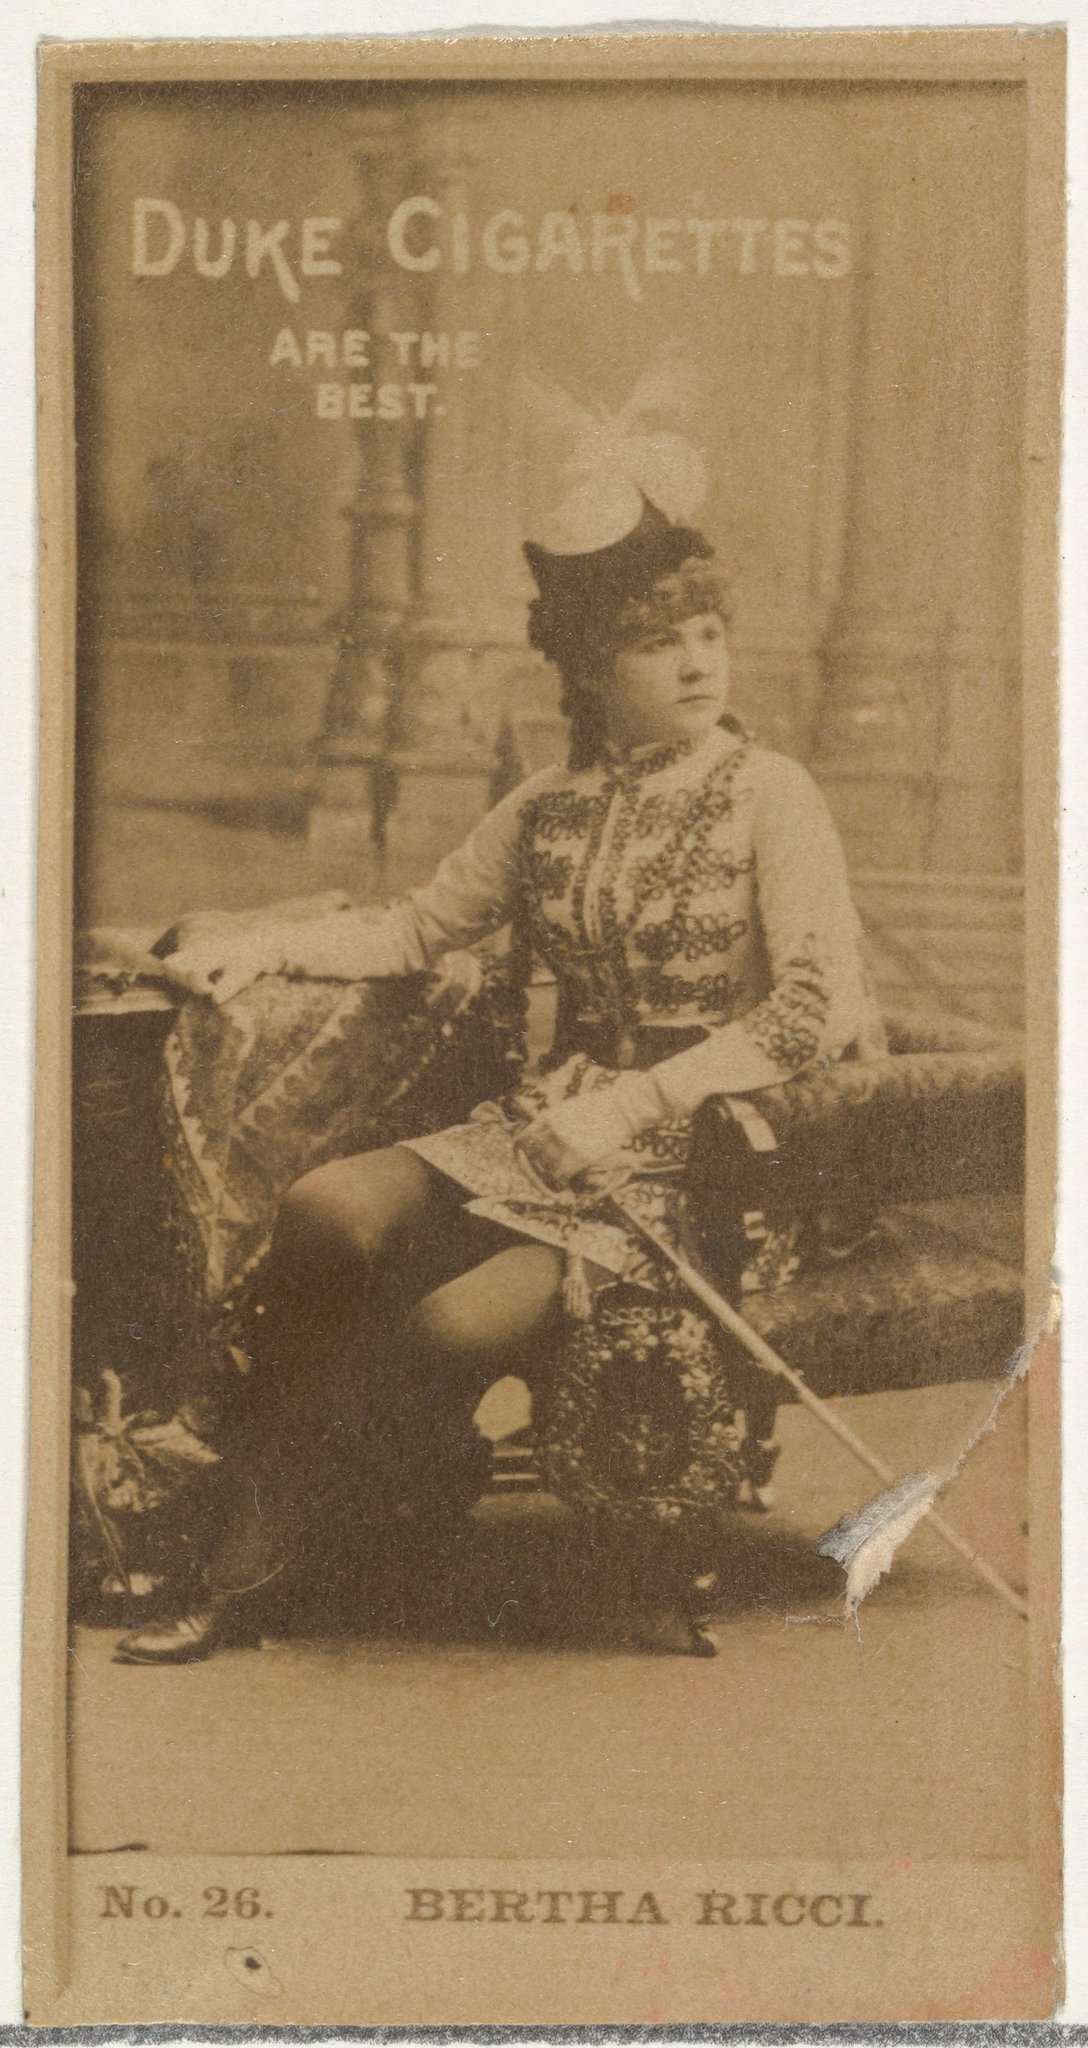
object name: photograph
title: Card Number 26, Bertha Ricci, from the Actors and Actresses series (N145-6) issued by Duke Sons & Co. to promote Duke Cigarettes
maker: w. duke, sons & co.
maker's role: publisher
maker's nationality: american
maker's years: 1870-1920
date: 1880-1889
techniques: albumen silver print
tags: portraits,women,actresses